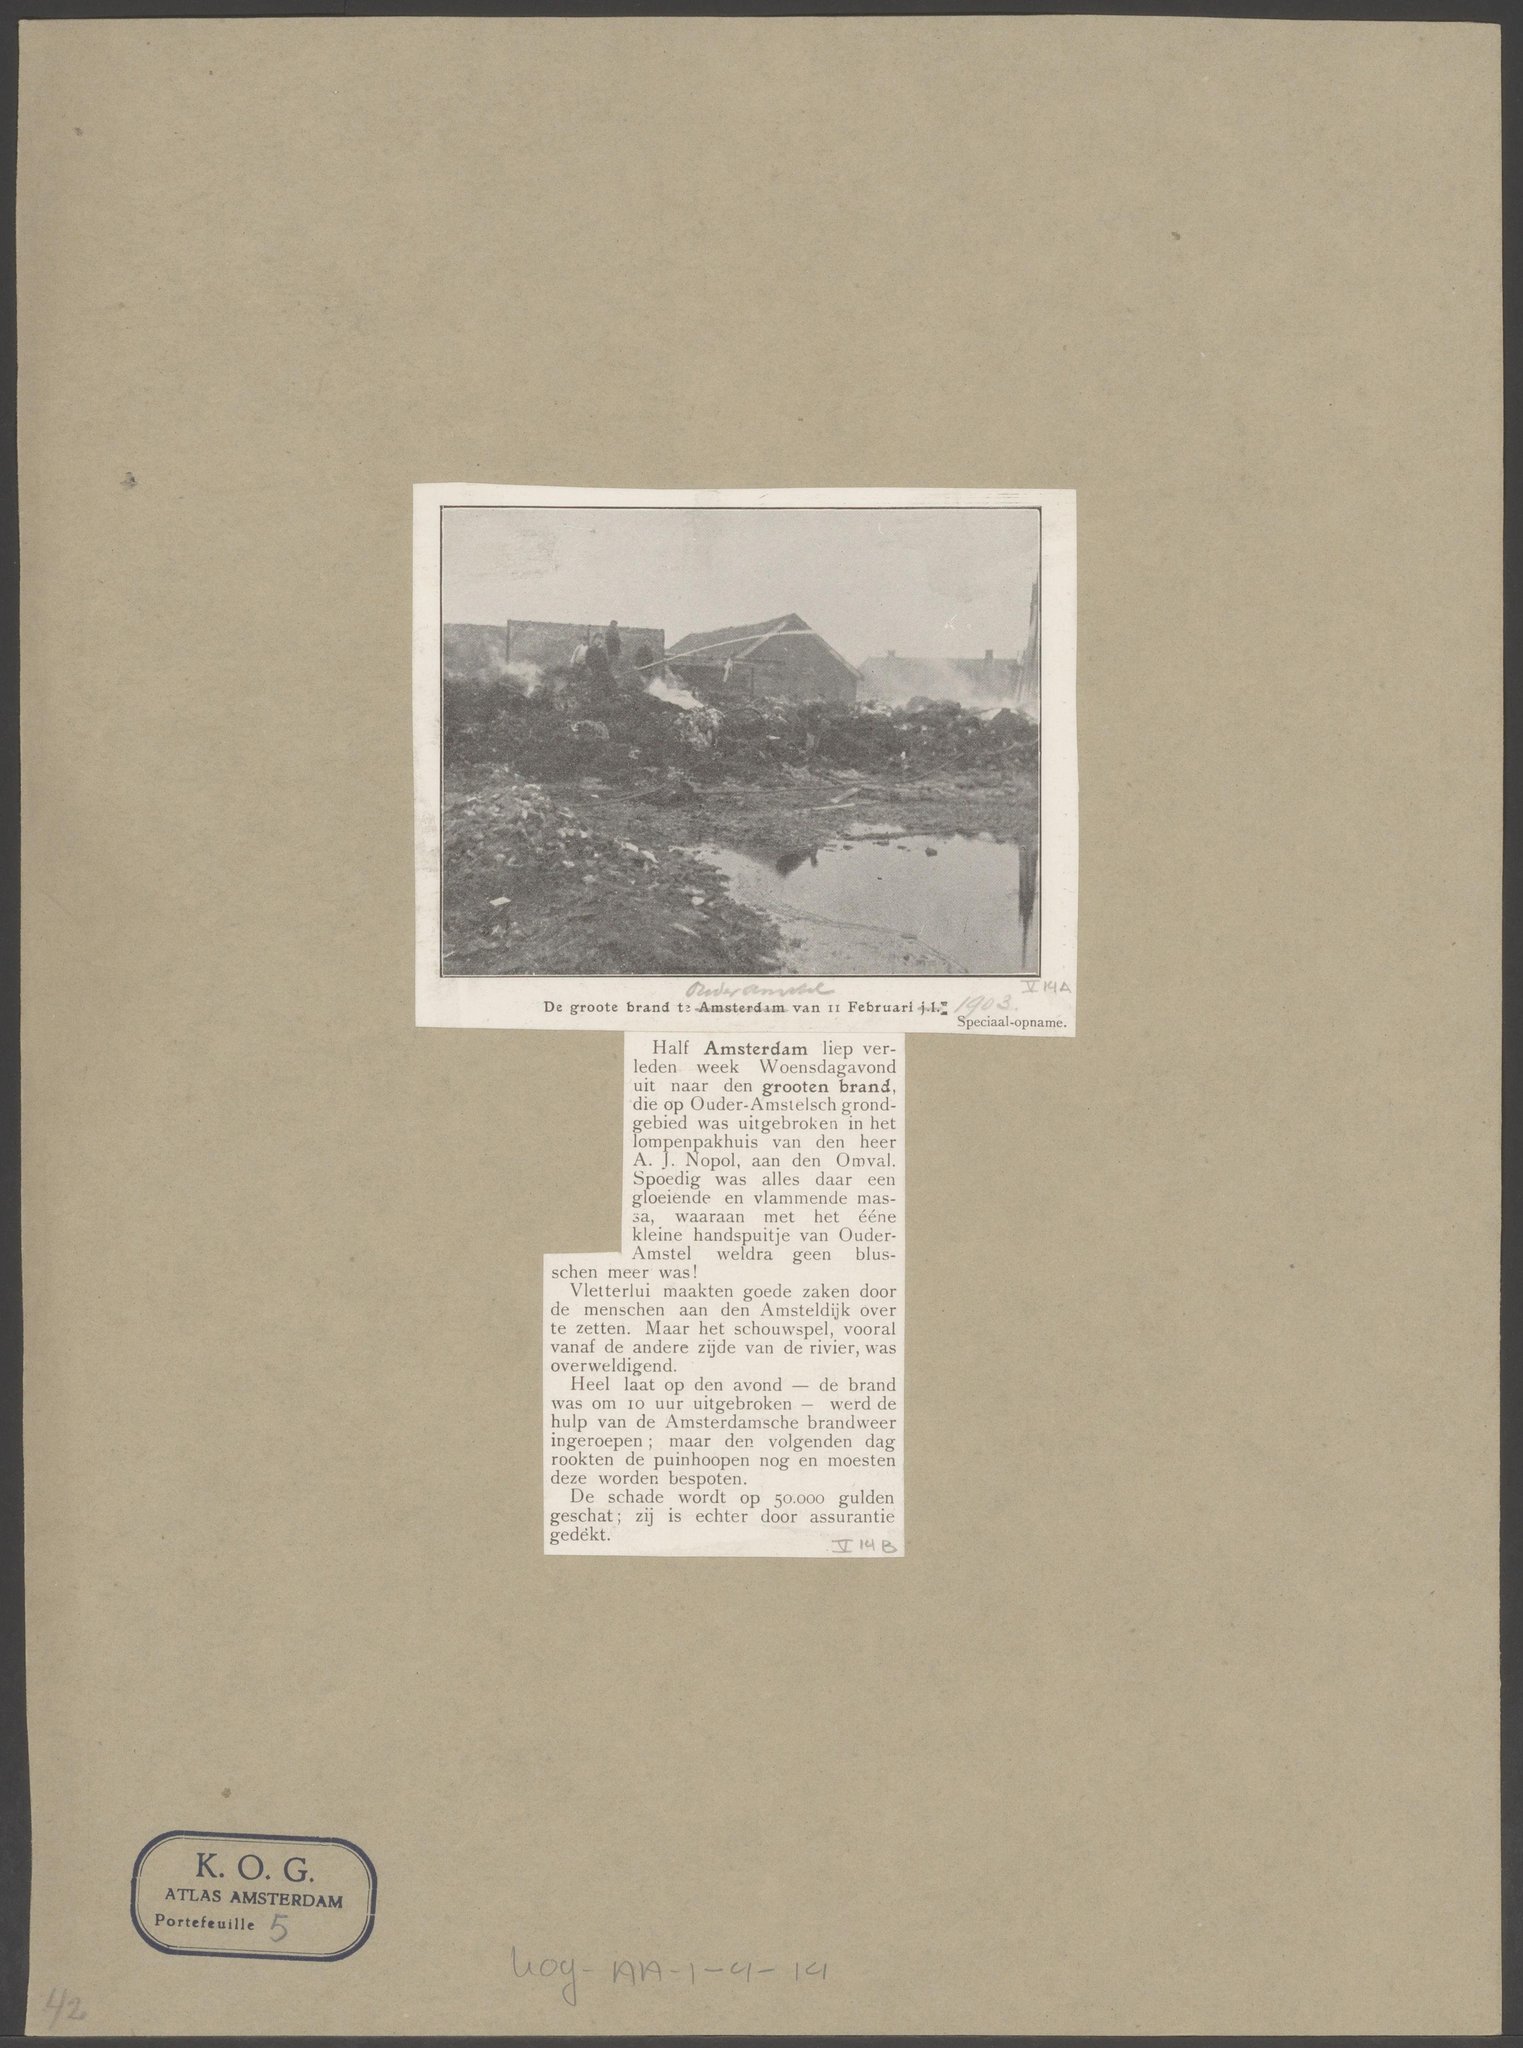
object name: photomechanical print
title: Gezicht op een brand bij een pakhuis bij de Ouder-Amstel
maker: Anonymous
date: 1903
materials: paper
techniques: letterpress printing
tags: large-scale structure for storage, e.g.: warehouse, depot, silo, on fire, ablaze, village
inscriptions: collector's mark: ‘5’ Lugt 1641b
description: Onderwerpsrubriek binnen de Atlas Amsterdam: Amstel buiten de stad, Amsteldijk.